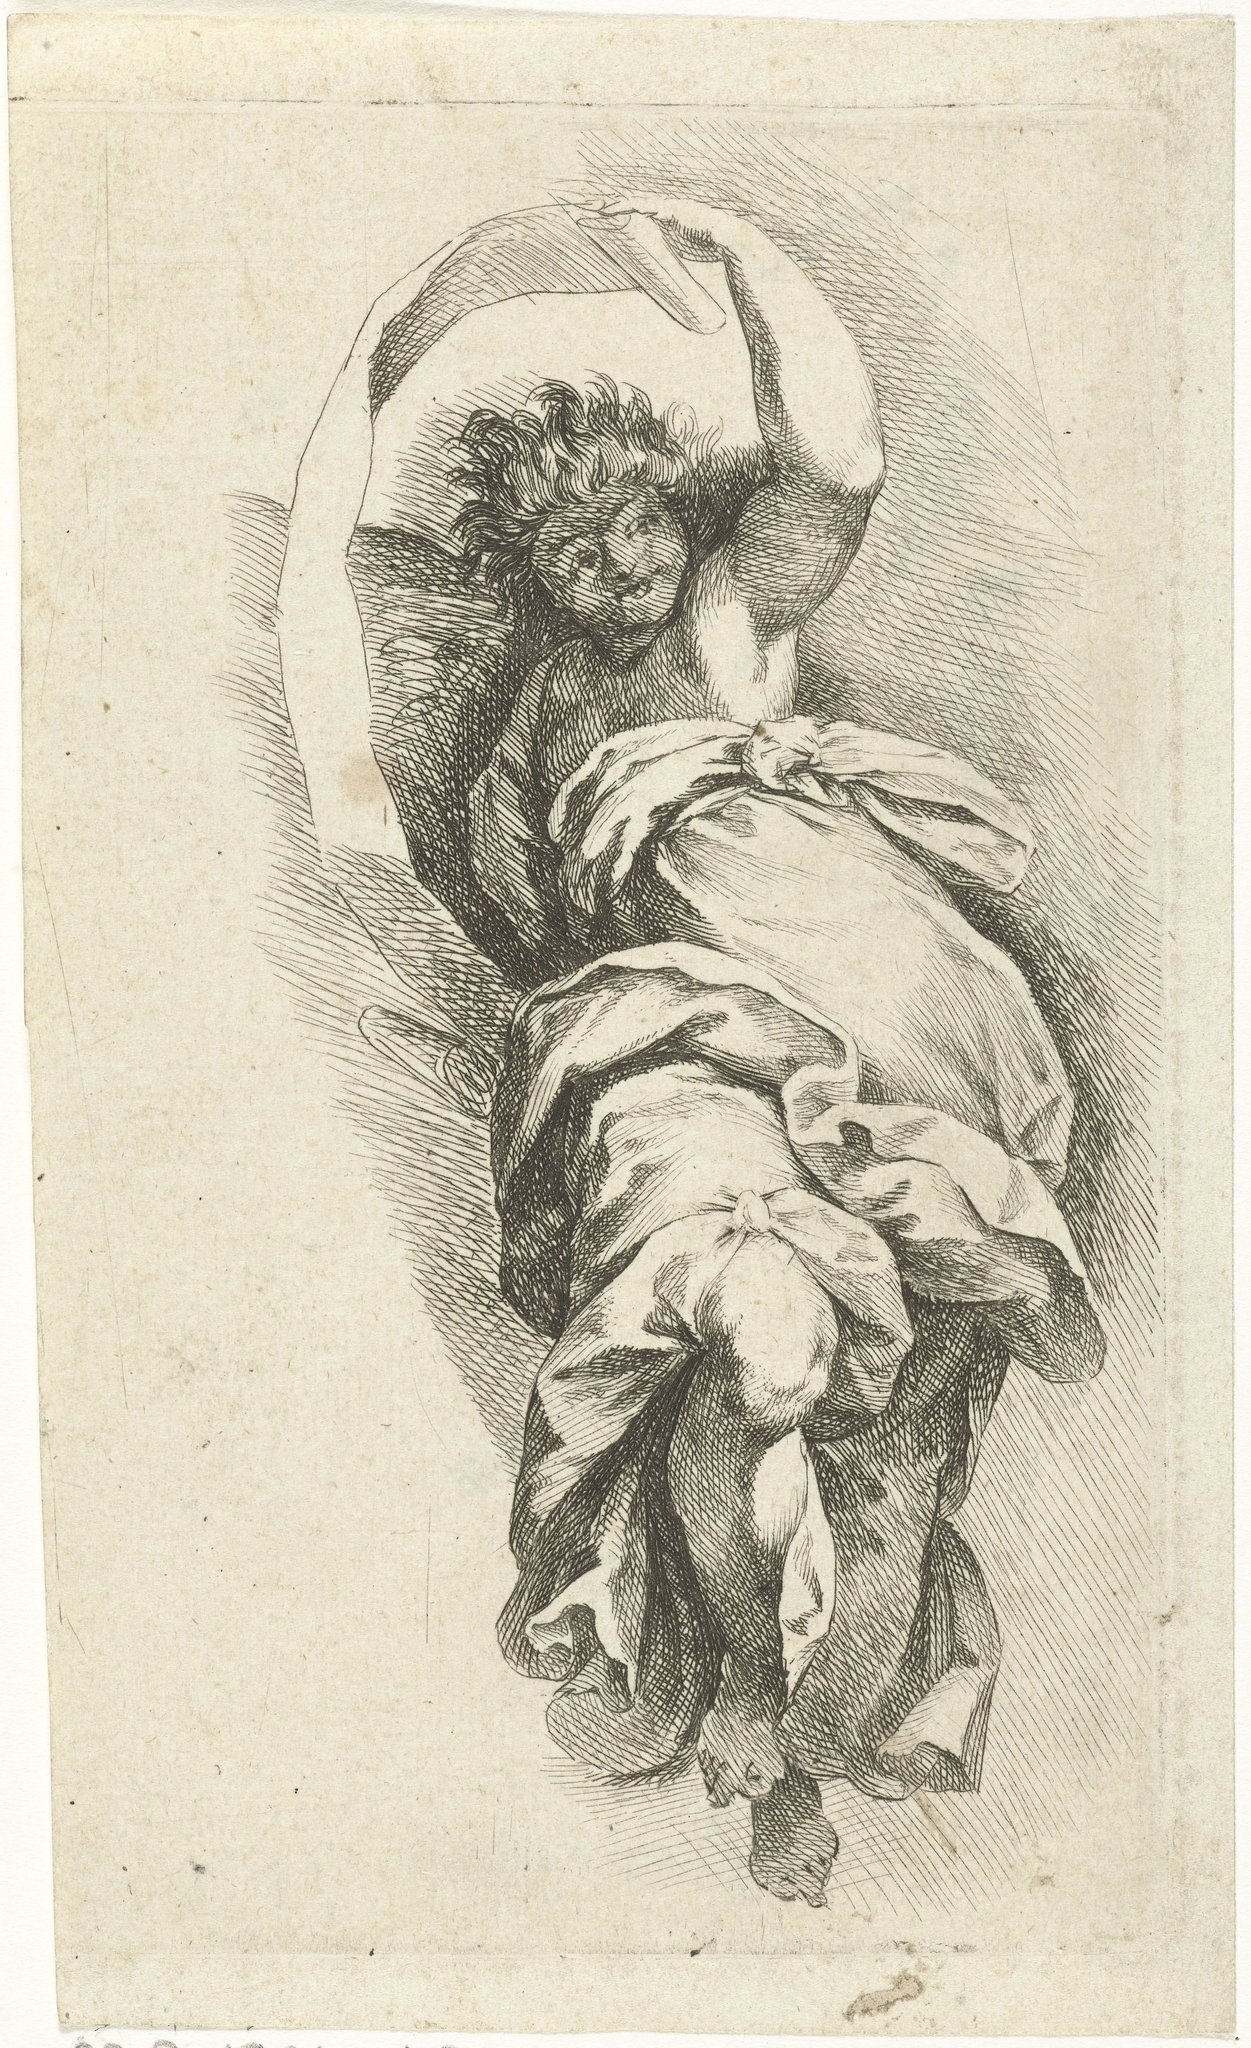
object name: print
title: Zwevende engel met banderol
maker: jan de bisschop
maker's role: draughtsman, print maker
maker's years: 1628-1671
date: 1668-1671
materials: paper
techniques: etching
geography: northern netherlands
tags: angel(s) with book(-scroll) or banderole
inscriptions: collector's mark: Lugt 2228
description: afkomstig uit: Paradigmata graphices variorum artificum : voor-beelden der teken-konst van verscheyde meesters, (2e of latere editie)